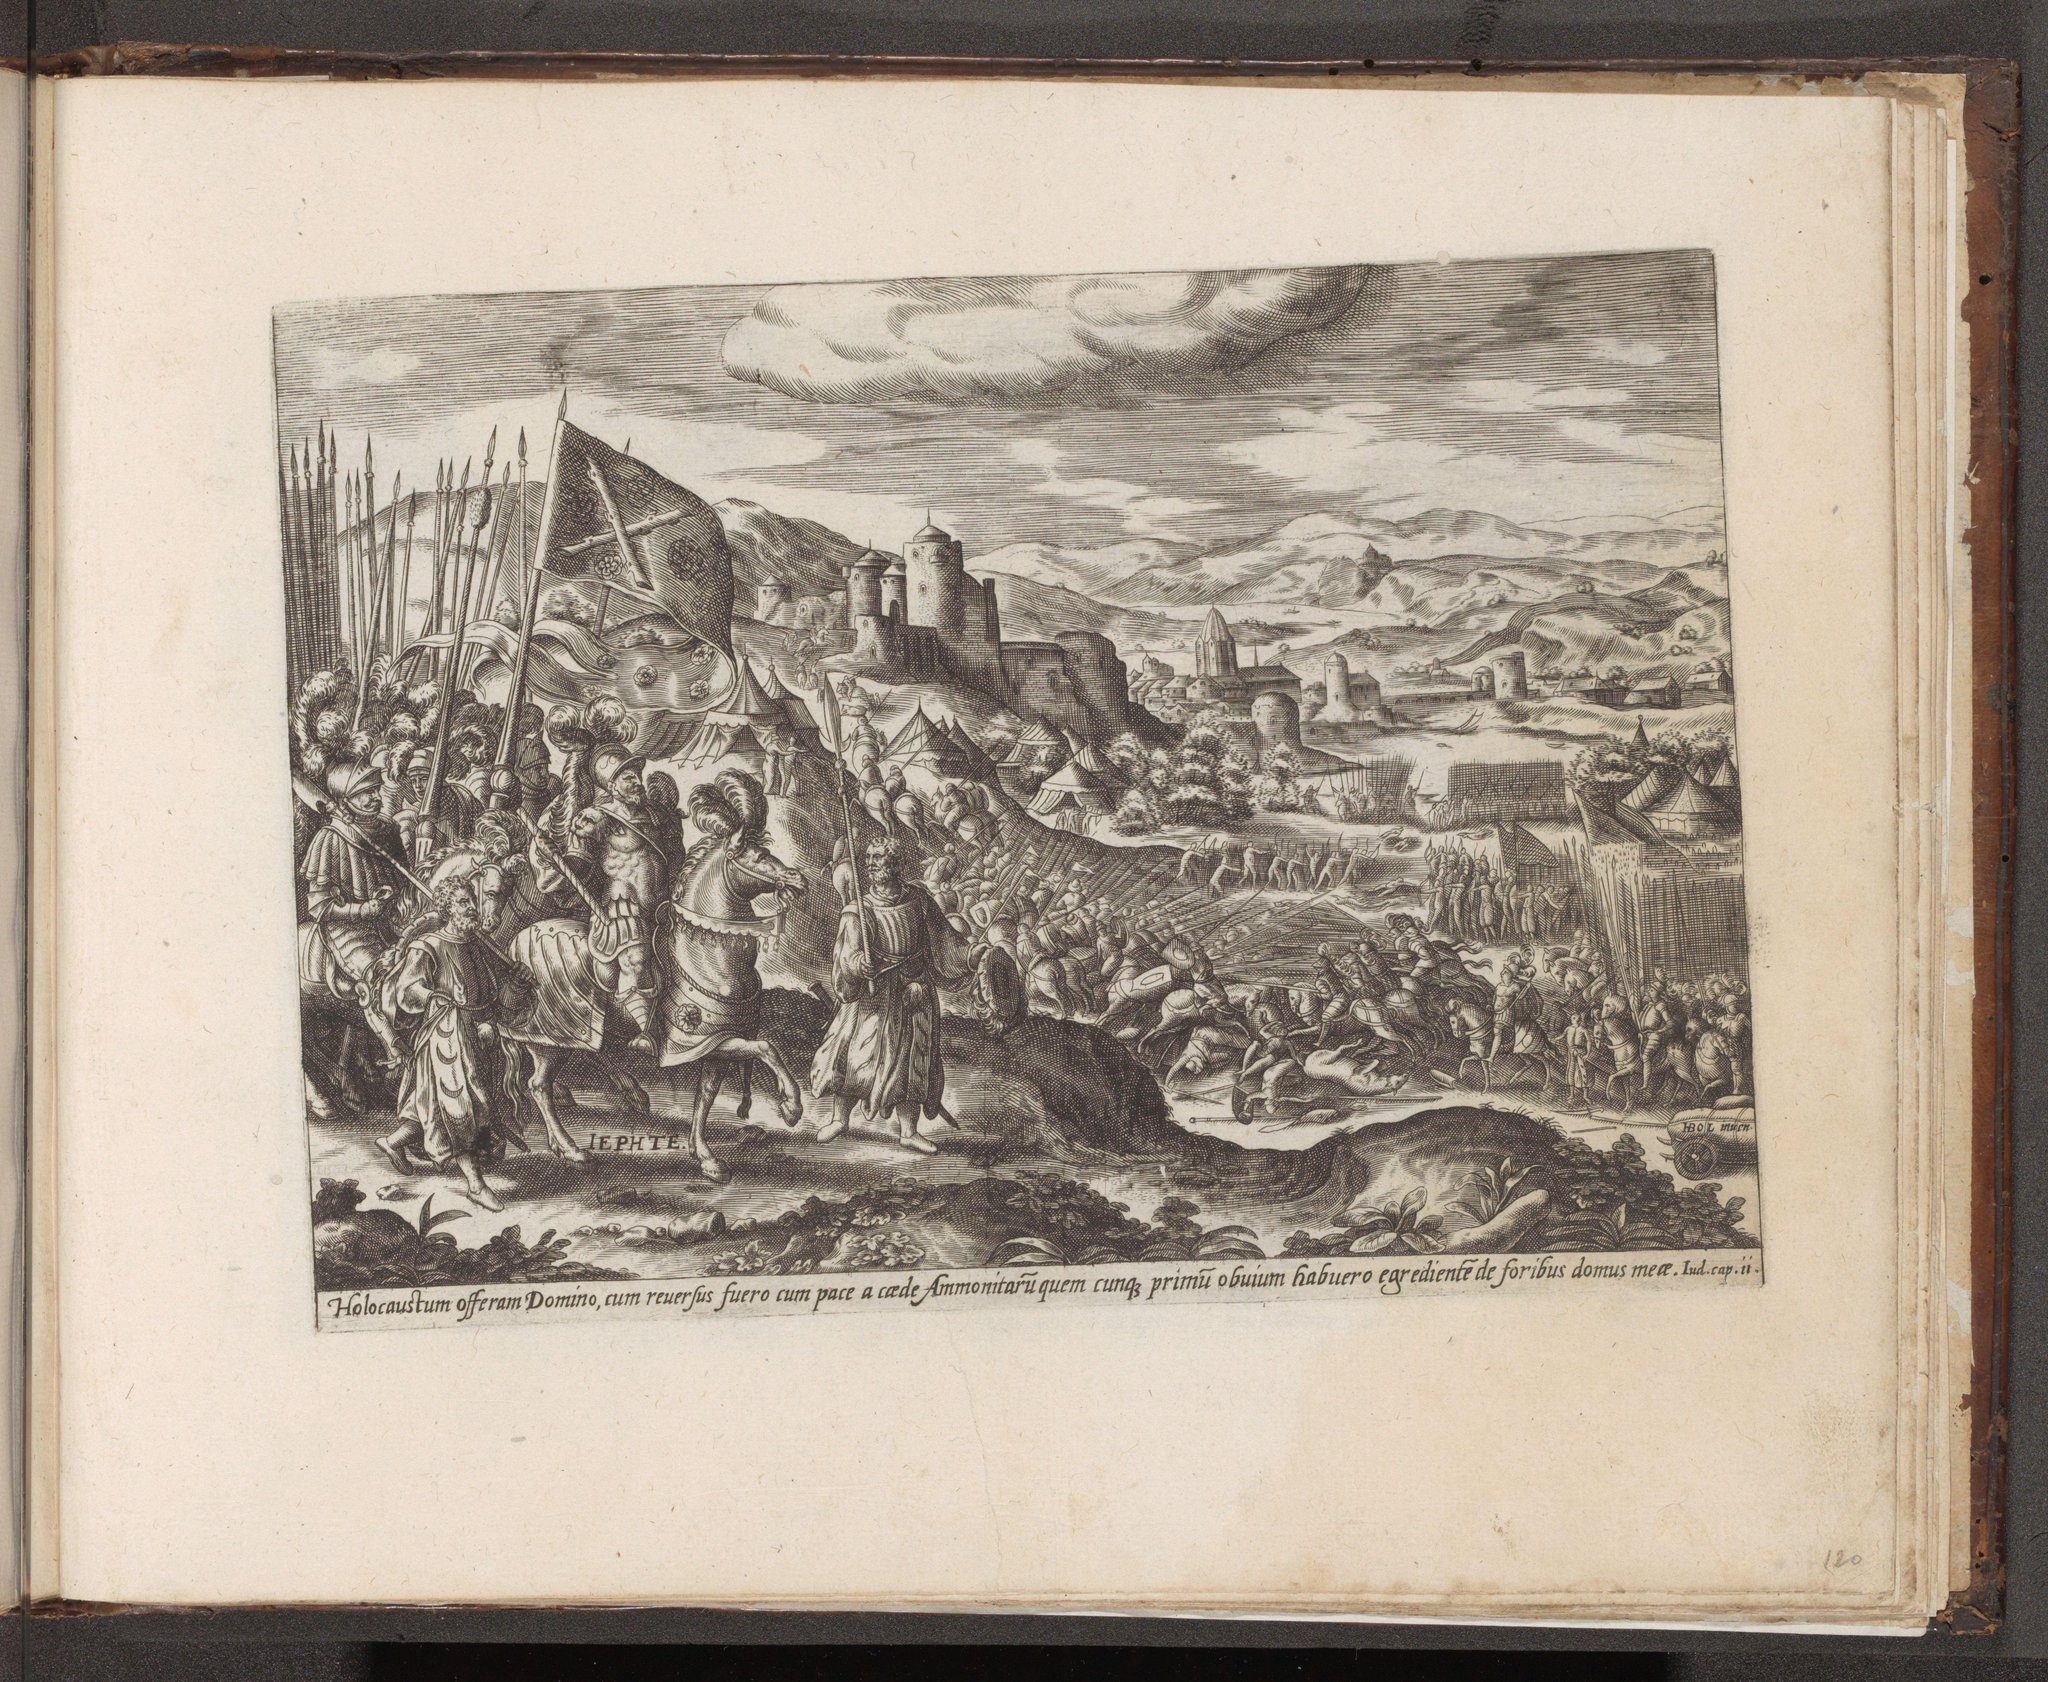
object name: album leaf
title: Historia Jeptes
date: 1579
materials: paper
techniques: engraving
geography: antwerp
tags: the ammonites are defeated by jephthah's army; twenty cities are taken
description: Jefta, de aanvoerder en leider van Israël, zit geharnast te paard en trekt op tegen de Ammonieten. Hij wordt gevolgd door zijn leger. In het landschap vechten Jefta's mannen tegen de Ammonieten en verslaan hen. Onder de voorstelling een verwijzing in het Latijn naar de Bijbeltekst in Ri. 11. Prent maakt deel uit van een album.